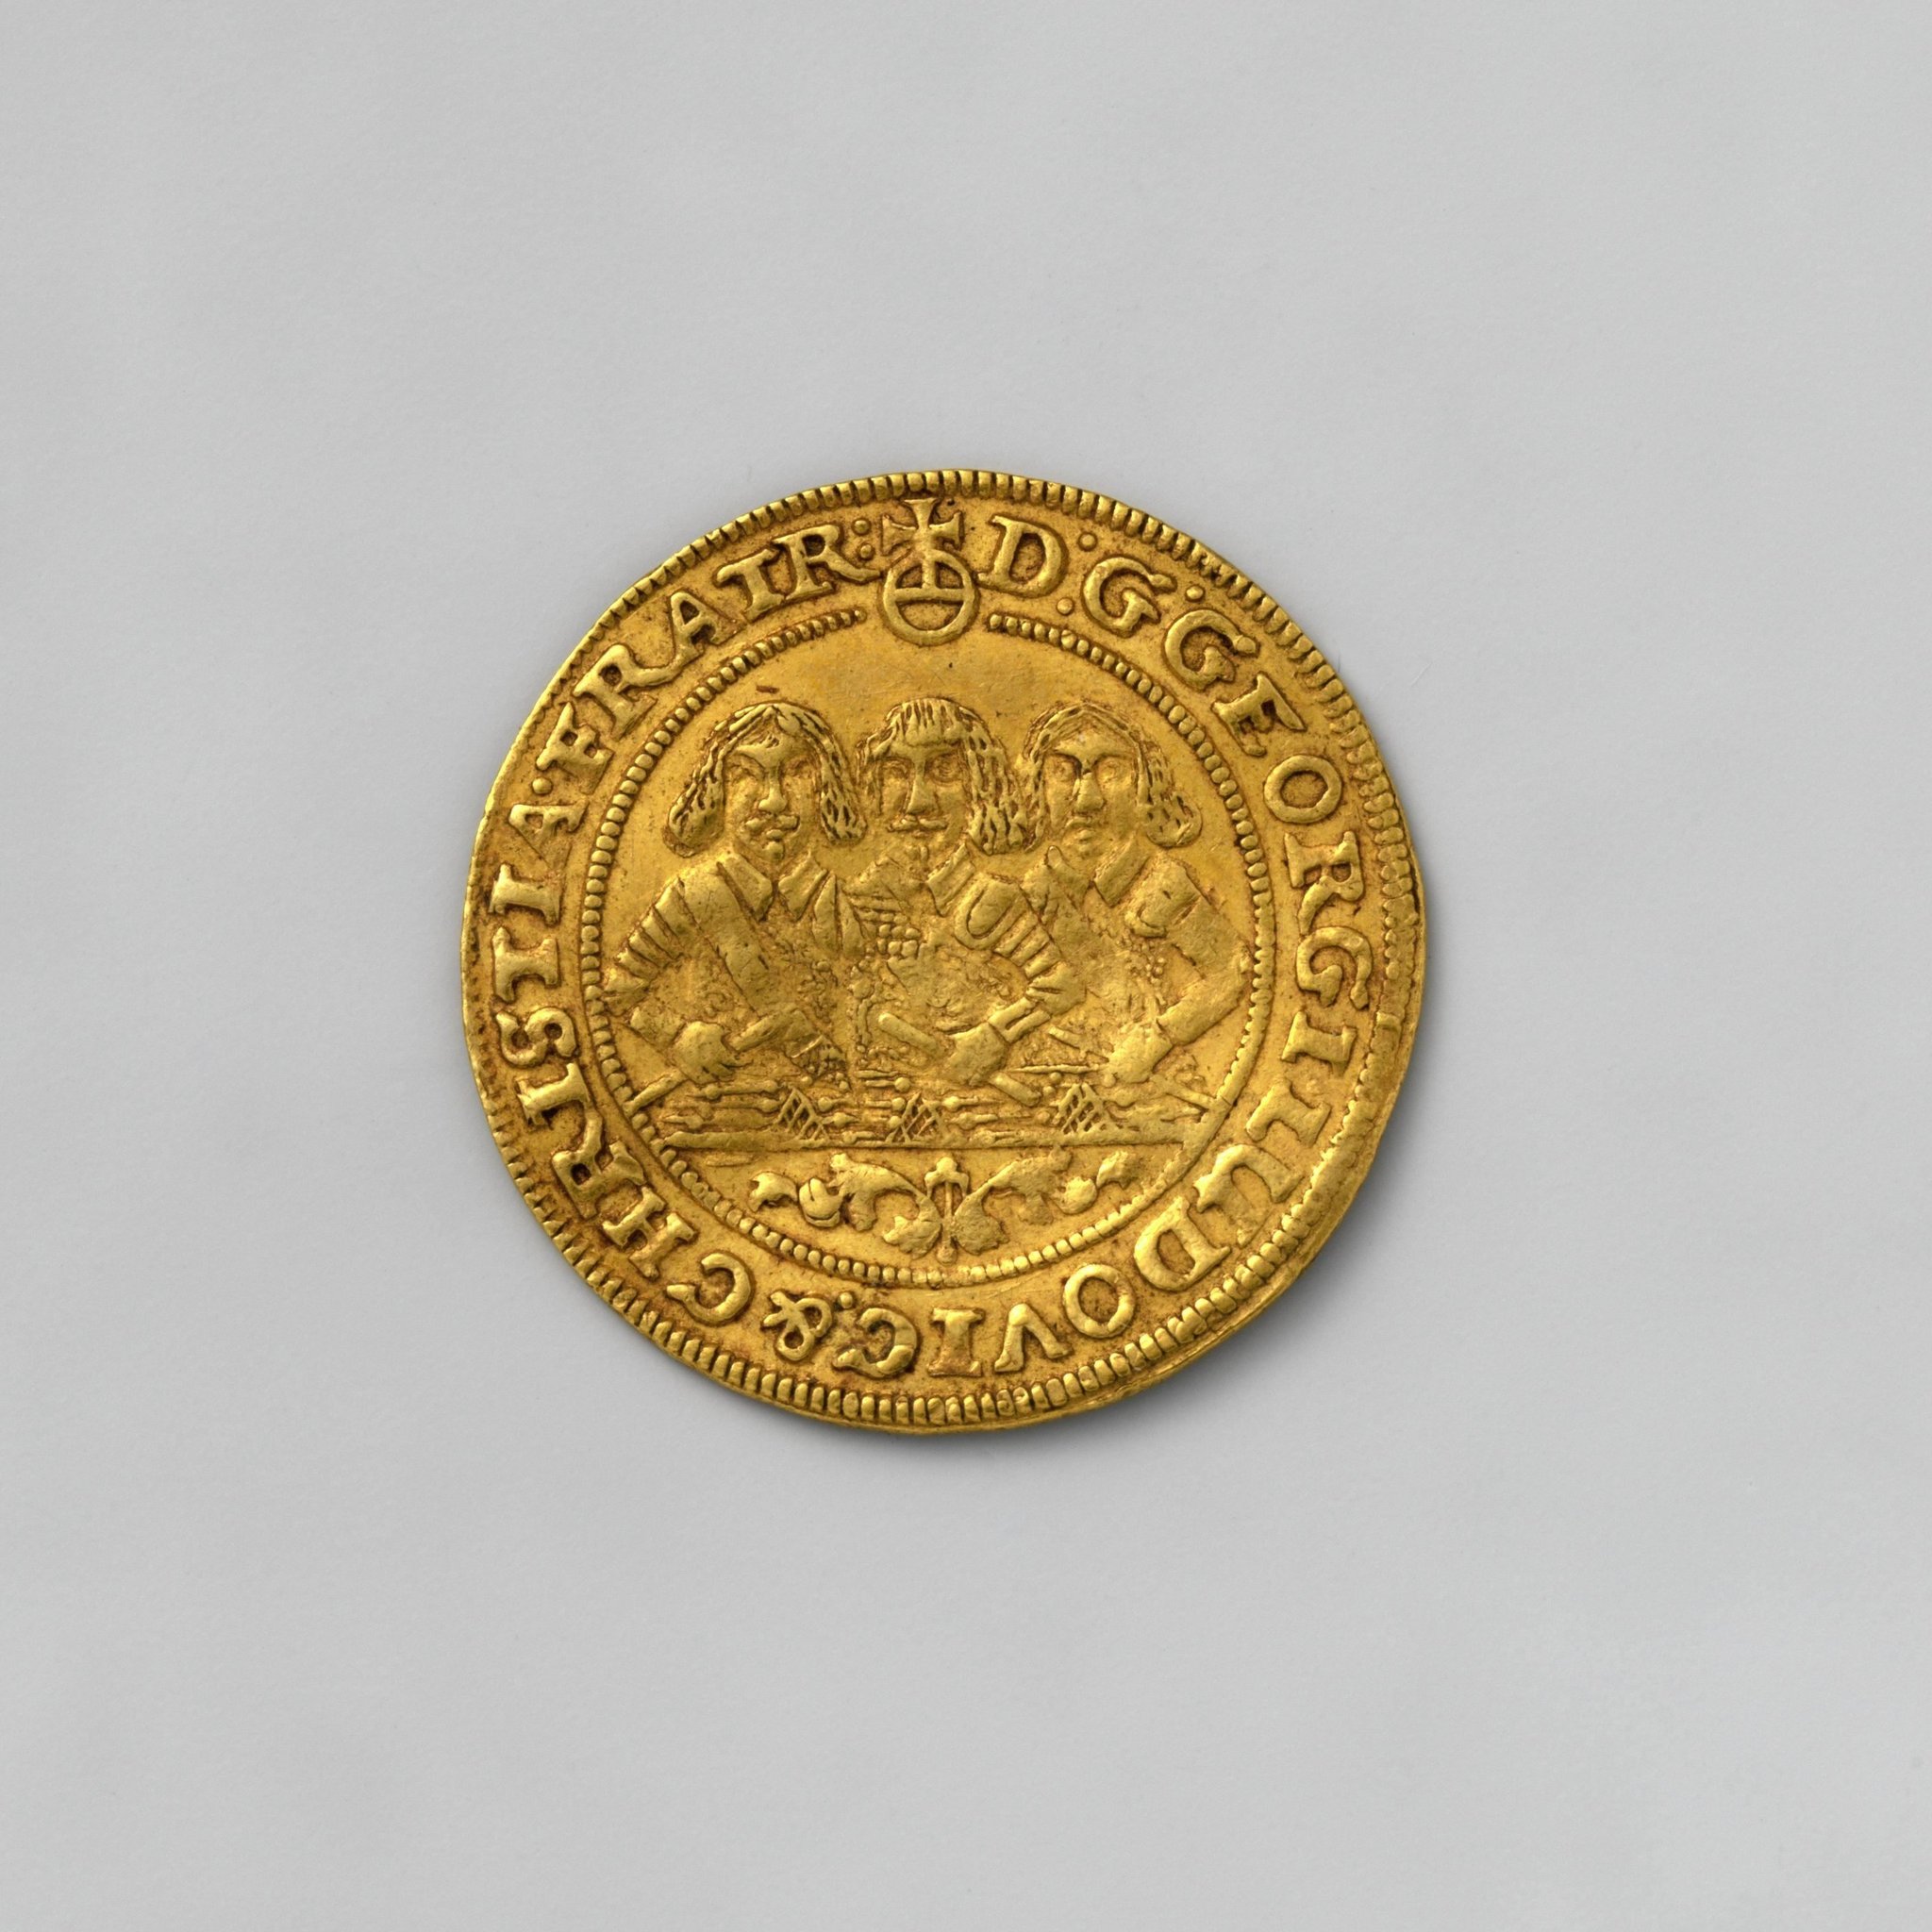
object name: coin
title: Hertogdom Liegnitz-Brieg, Georg III, Ludwig IV en Christian, dukaat, 1656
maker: christian pfahler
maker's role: mintmaster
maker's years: 1603-1665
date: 1656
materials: gold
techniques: striking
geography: brieg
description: Gouden munt. Voorzijde: portretten van de drie hertogen op een rij. Keerzijde: samengesteld wapenschild met helm en helmtekens. Jaartal in omschrift bovenaan.